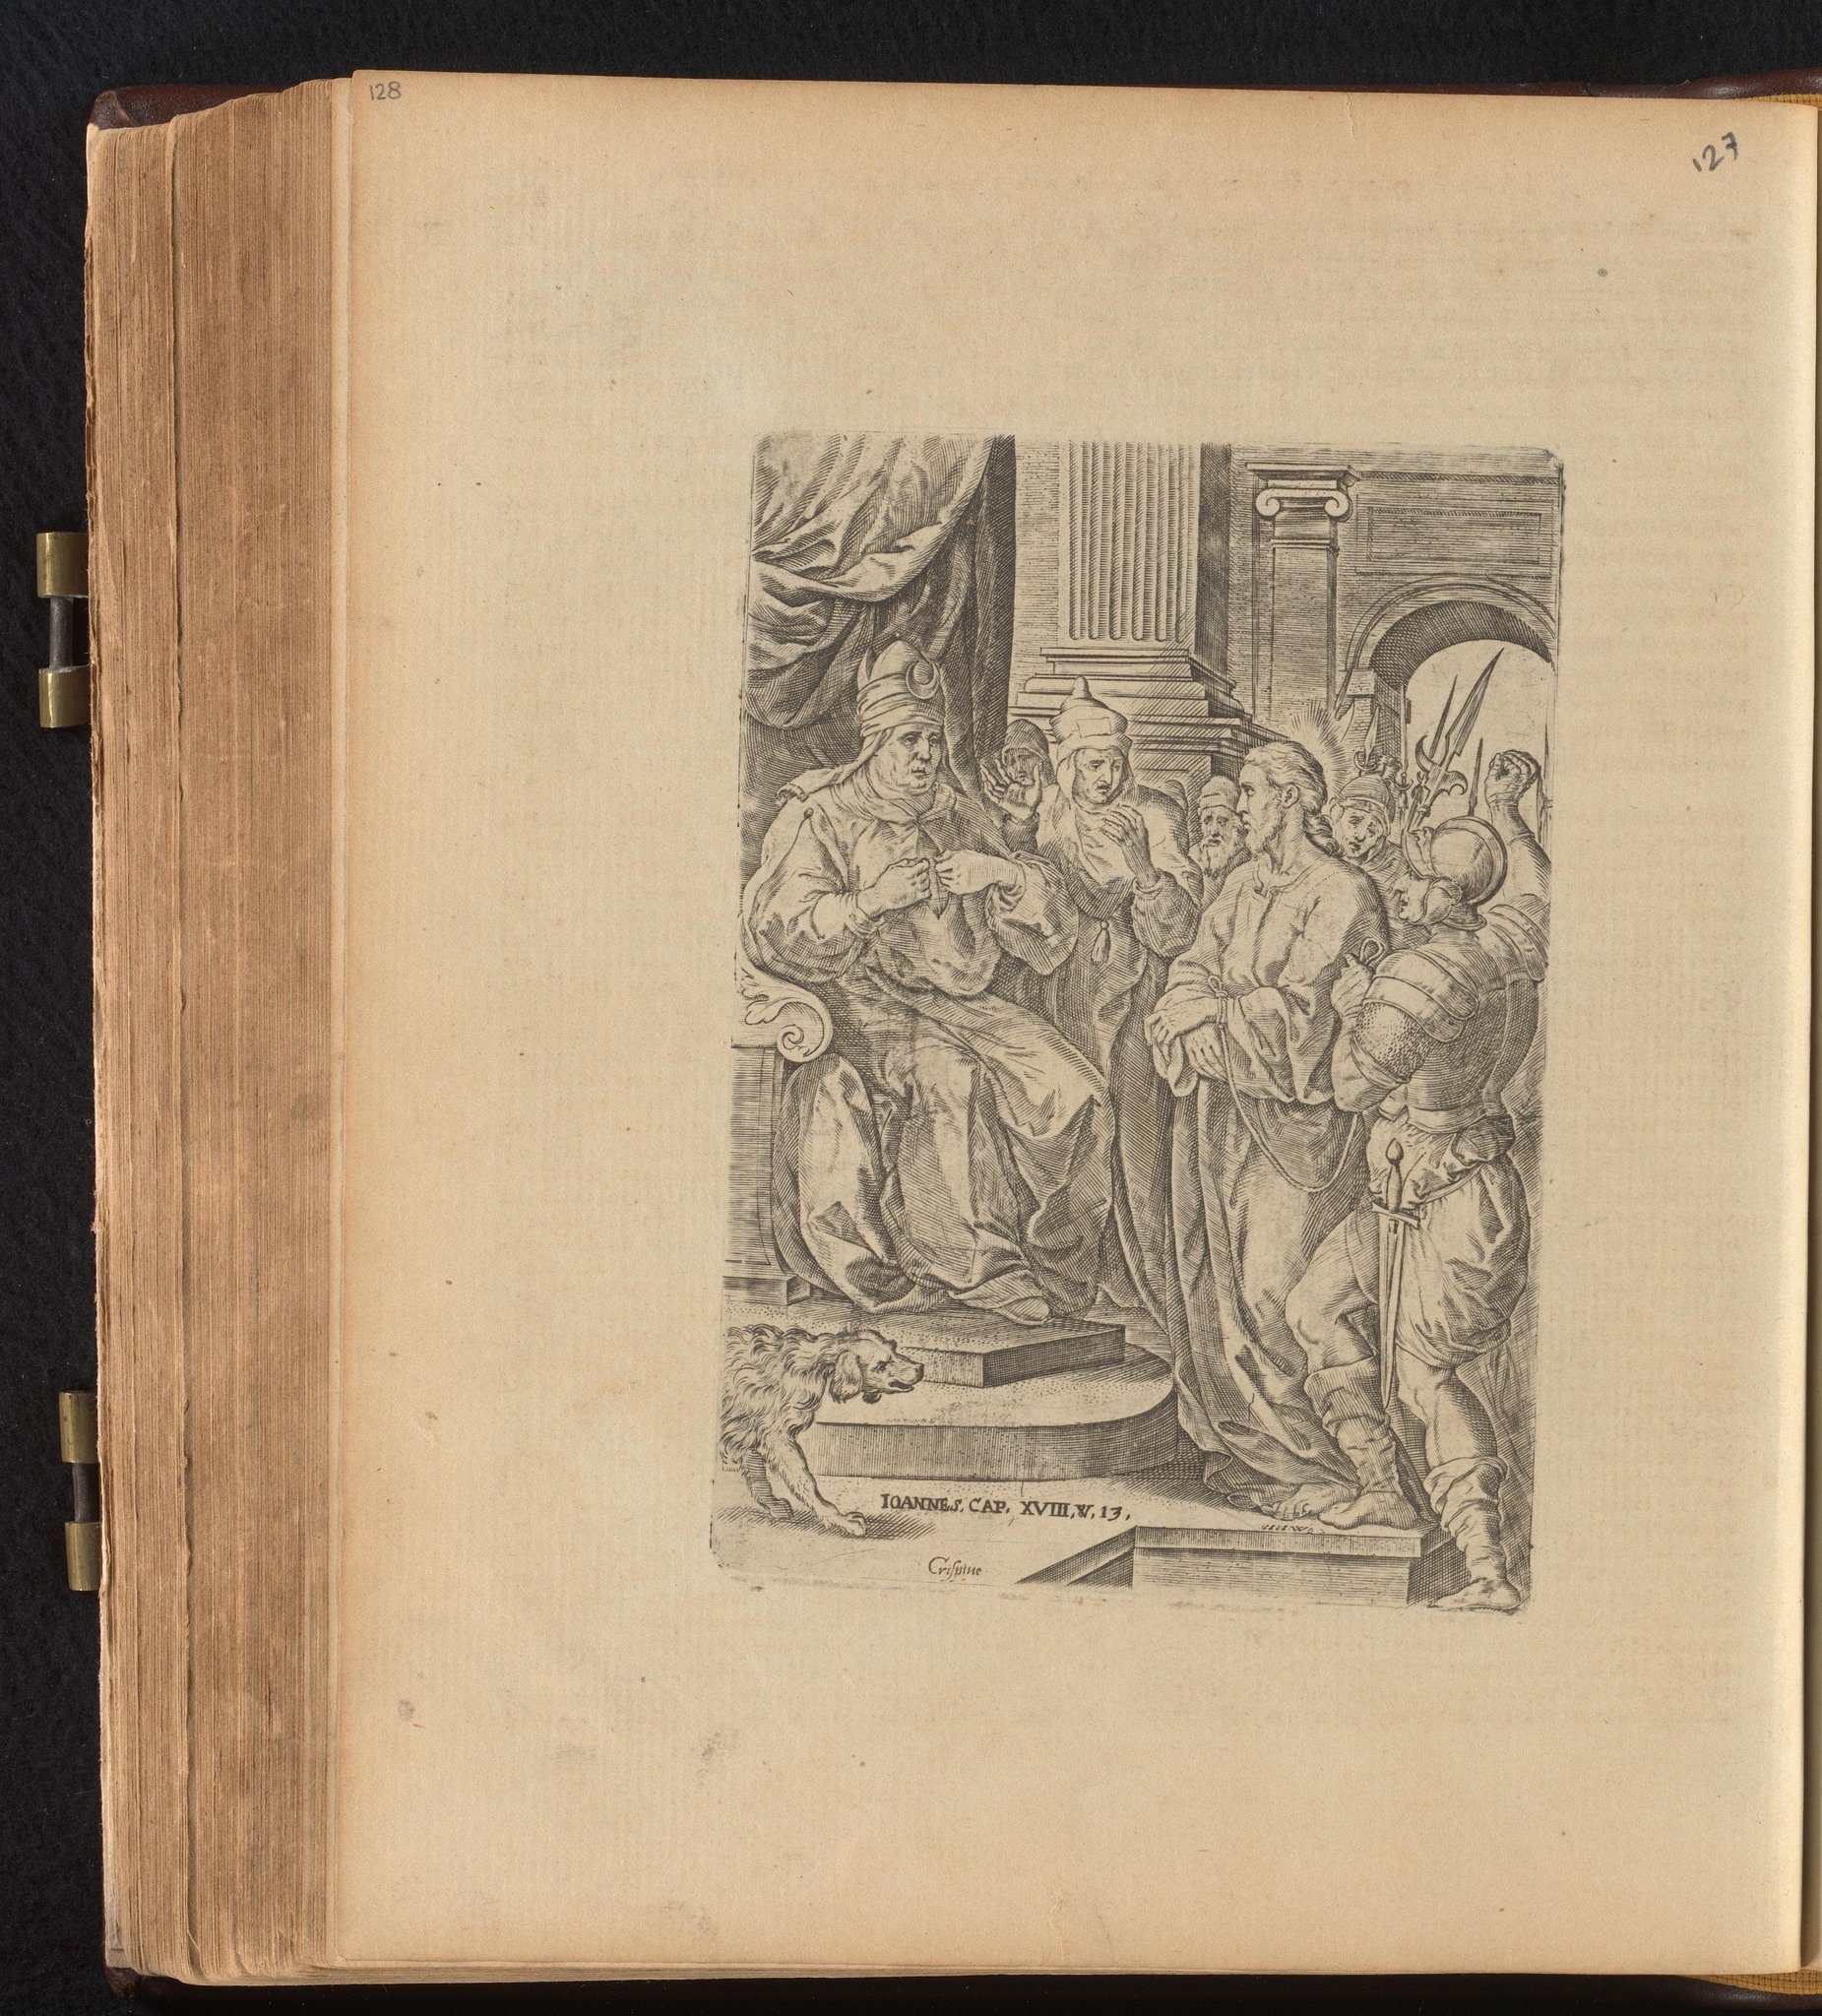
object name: print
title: Christus voor Kajafas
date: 1576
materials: paper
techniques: engraving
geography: antwerp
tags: christ before the sanhedrin with caiaphas as high priest, and possibly annas; maybe a soldier about to strike christ because he keeps silent (matthew 26:57-66; mark 14:53-64; luke 22:54, 22:66-71)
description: Eerdere staat van prent gebruikt als boekillustratie in: Theatrum Typpographicum. Antwerpen: Jan Moretus, 1576. Ook gebruikt in: Biblia Sacra. Antwerpen: Christoffel Plantijn, 1583. en Humanae salutis Monumenta. Antwerpen: Christoffel Plantijn, 1583.